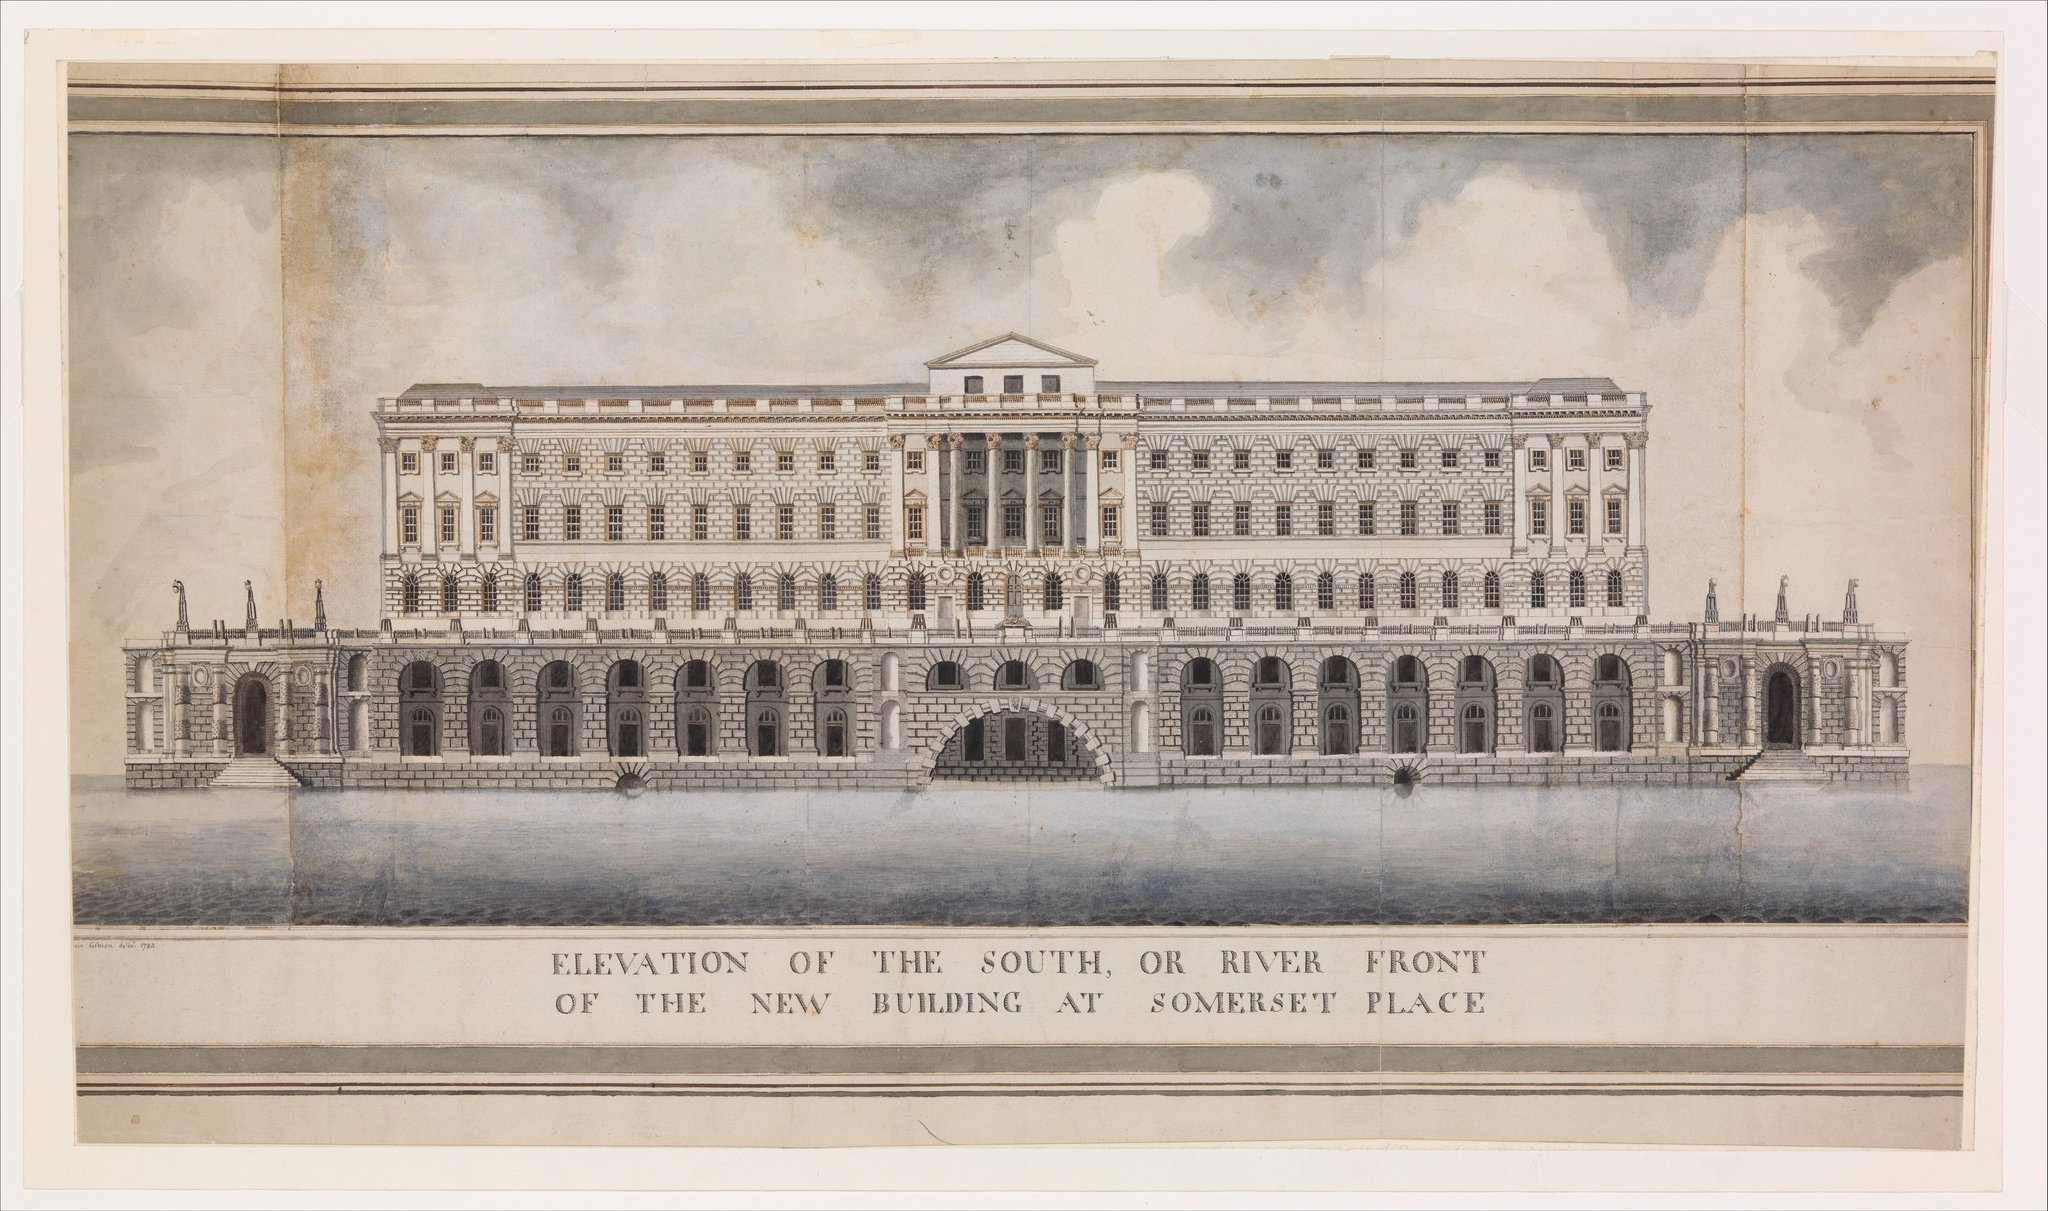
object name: drawing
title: Elevation of the South, or River Front of the New Building at Somerset Place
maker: sir william chambers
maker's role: artist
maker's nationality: british, born sweden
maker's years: 1723-1796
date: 1734-1800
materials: ink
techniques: brush, pen, wash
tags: buildings